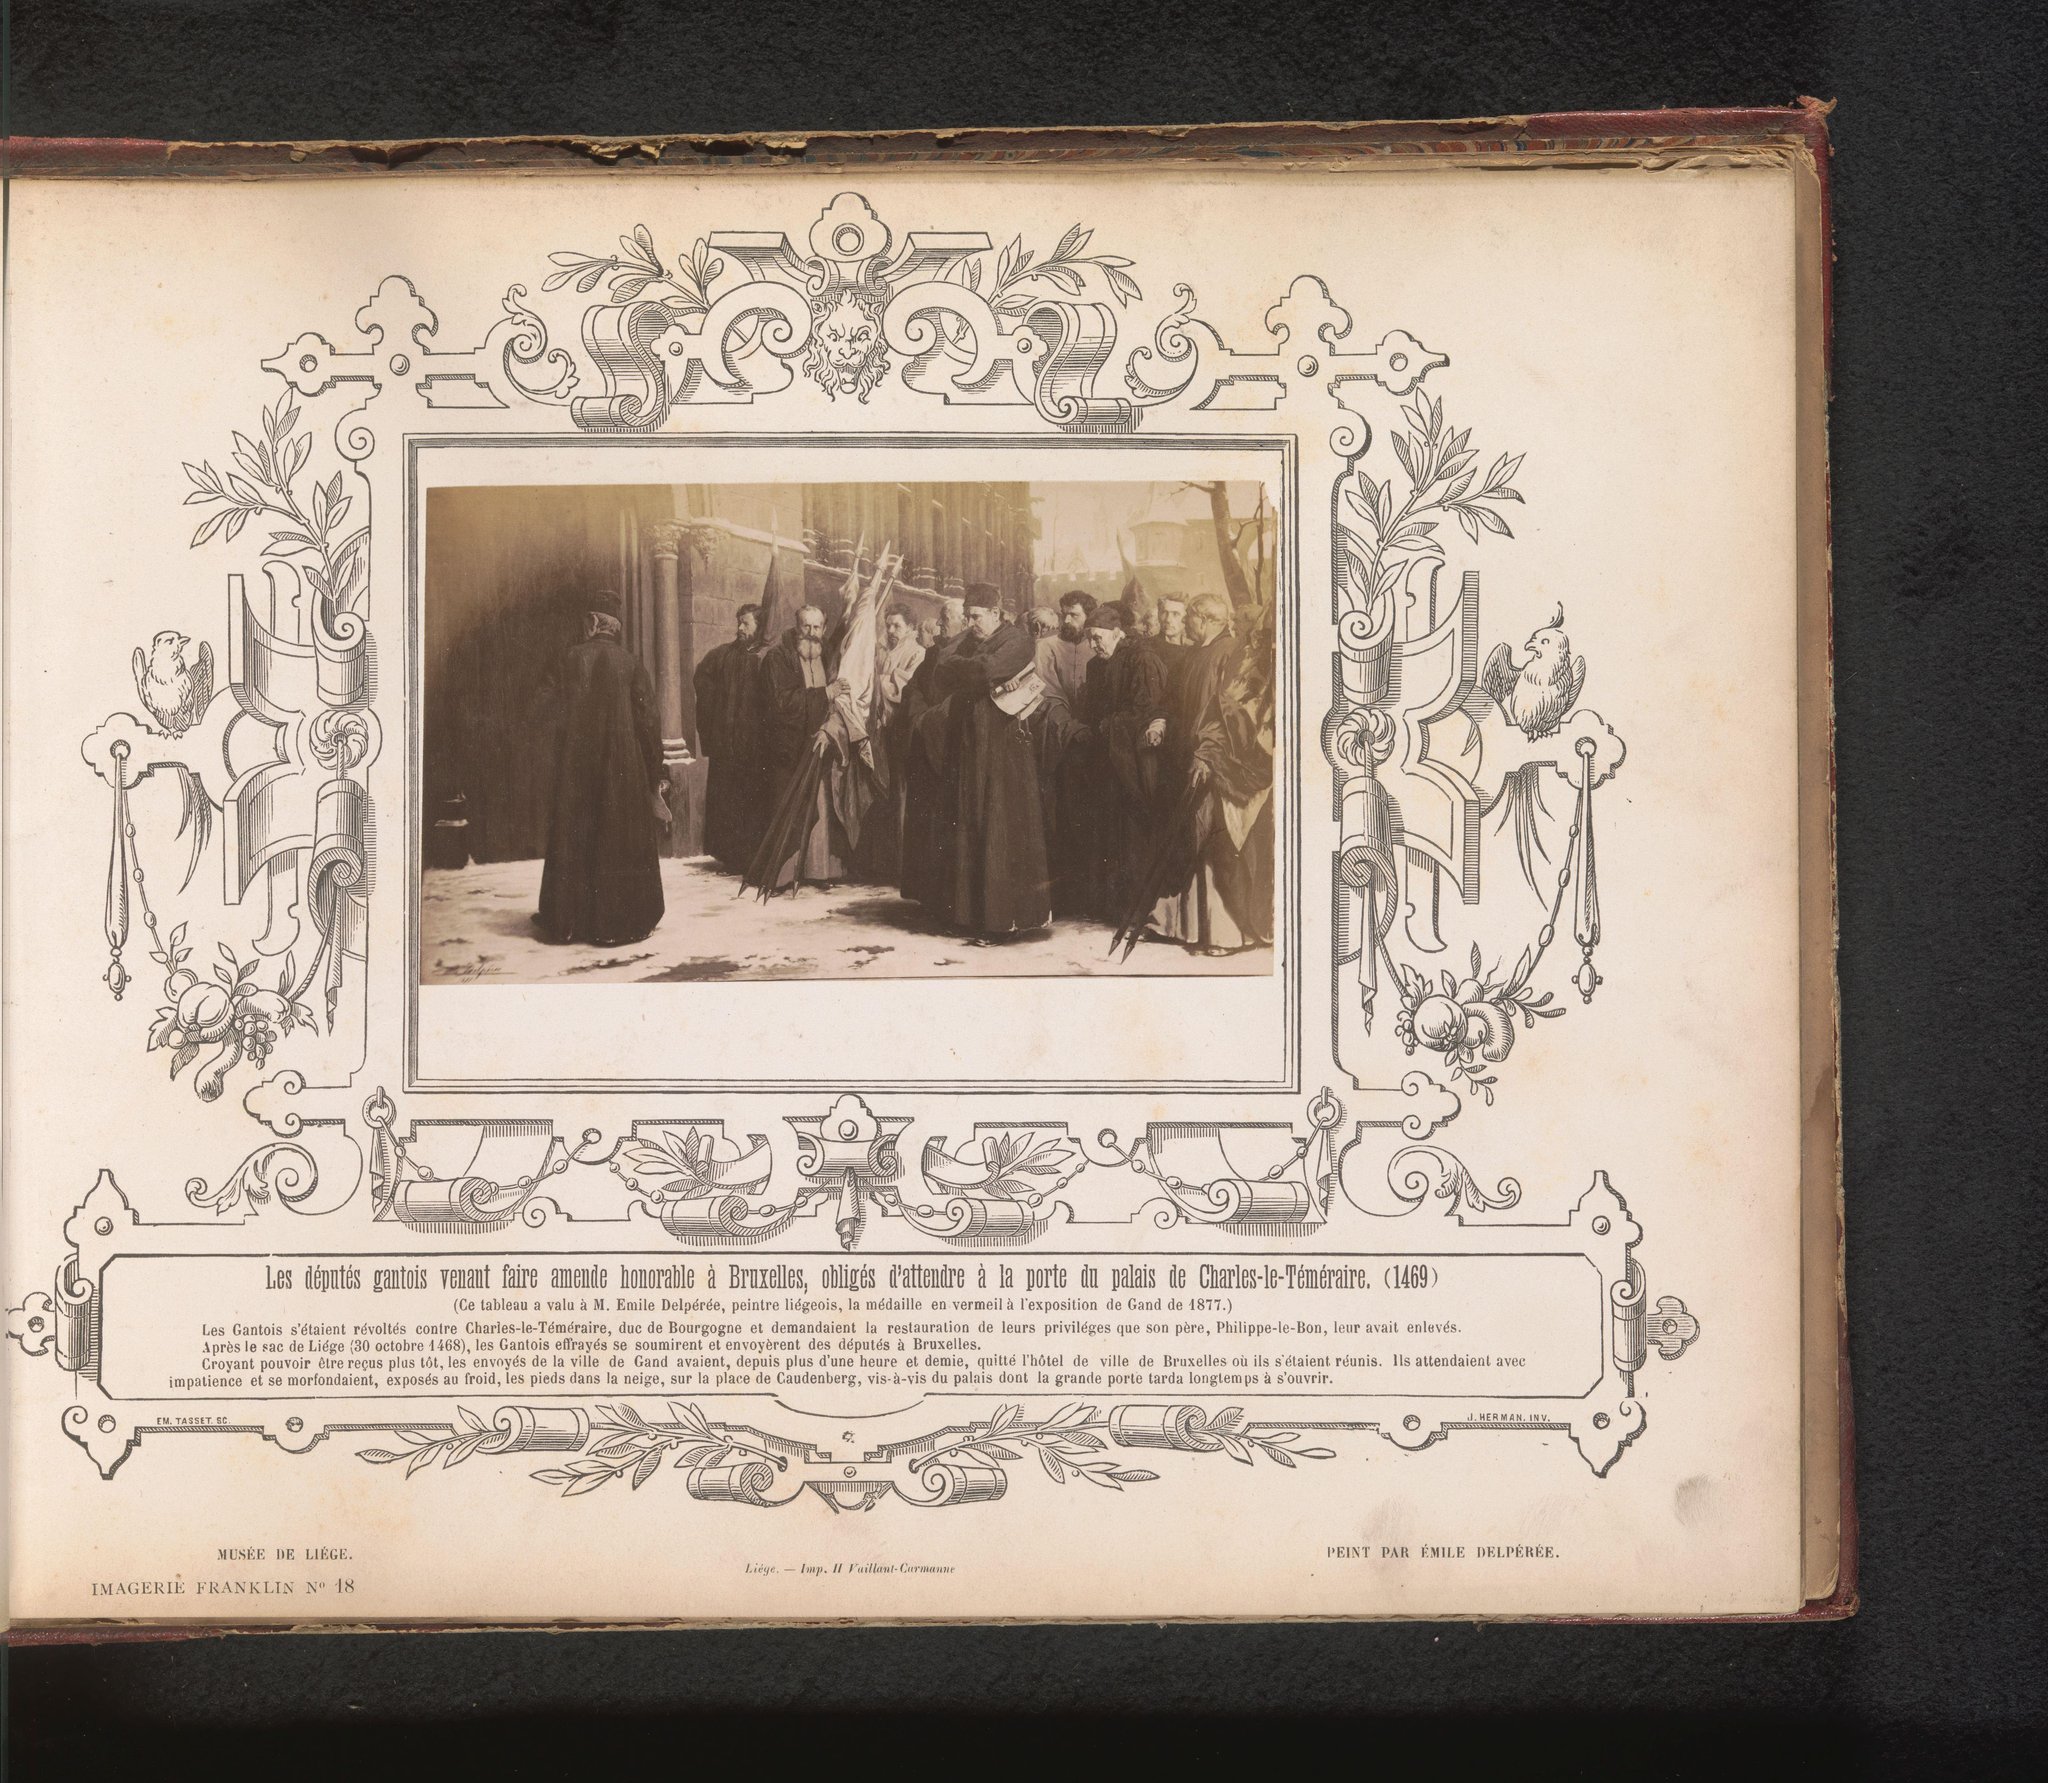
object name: page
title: Fotoreproductie van Les Députés Gantois Venant Faire Amende Honorable à Bruxelles, Obligés à la Porte du Palais de Charles-le-Téméraire door Émile Delperée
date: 1871-1880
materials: photographic support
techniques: albumen print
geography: liège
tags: adult man, closed door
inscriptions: inscription: ‘MUSÉE DE LIÉGE.’, name: ‘J. HERMAN, INV.’, inscription: ‘IMAGERIE FRANKLIN No 18.’, name: ‘EM. TASSET, SC.’, inscription: ‘(Ce tableau (...) à s'ouvrir.’